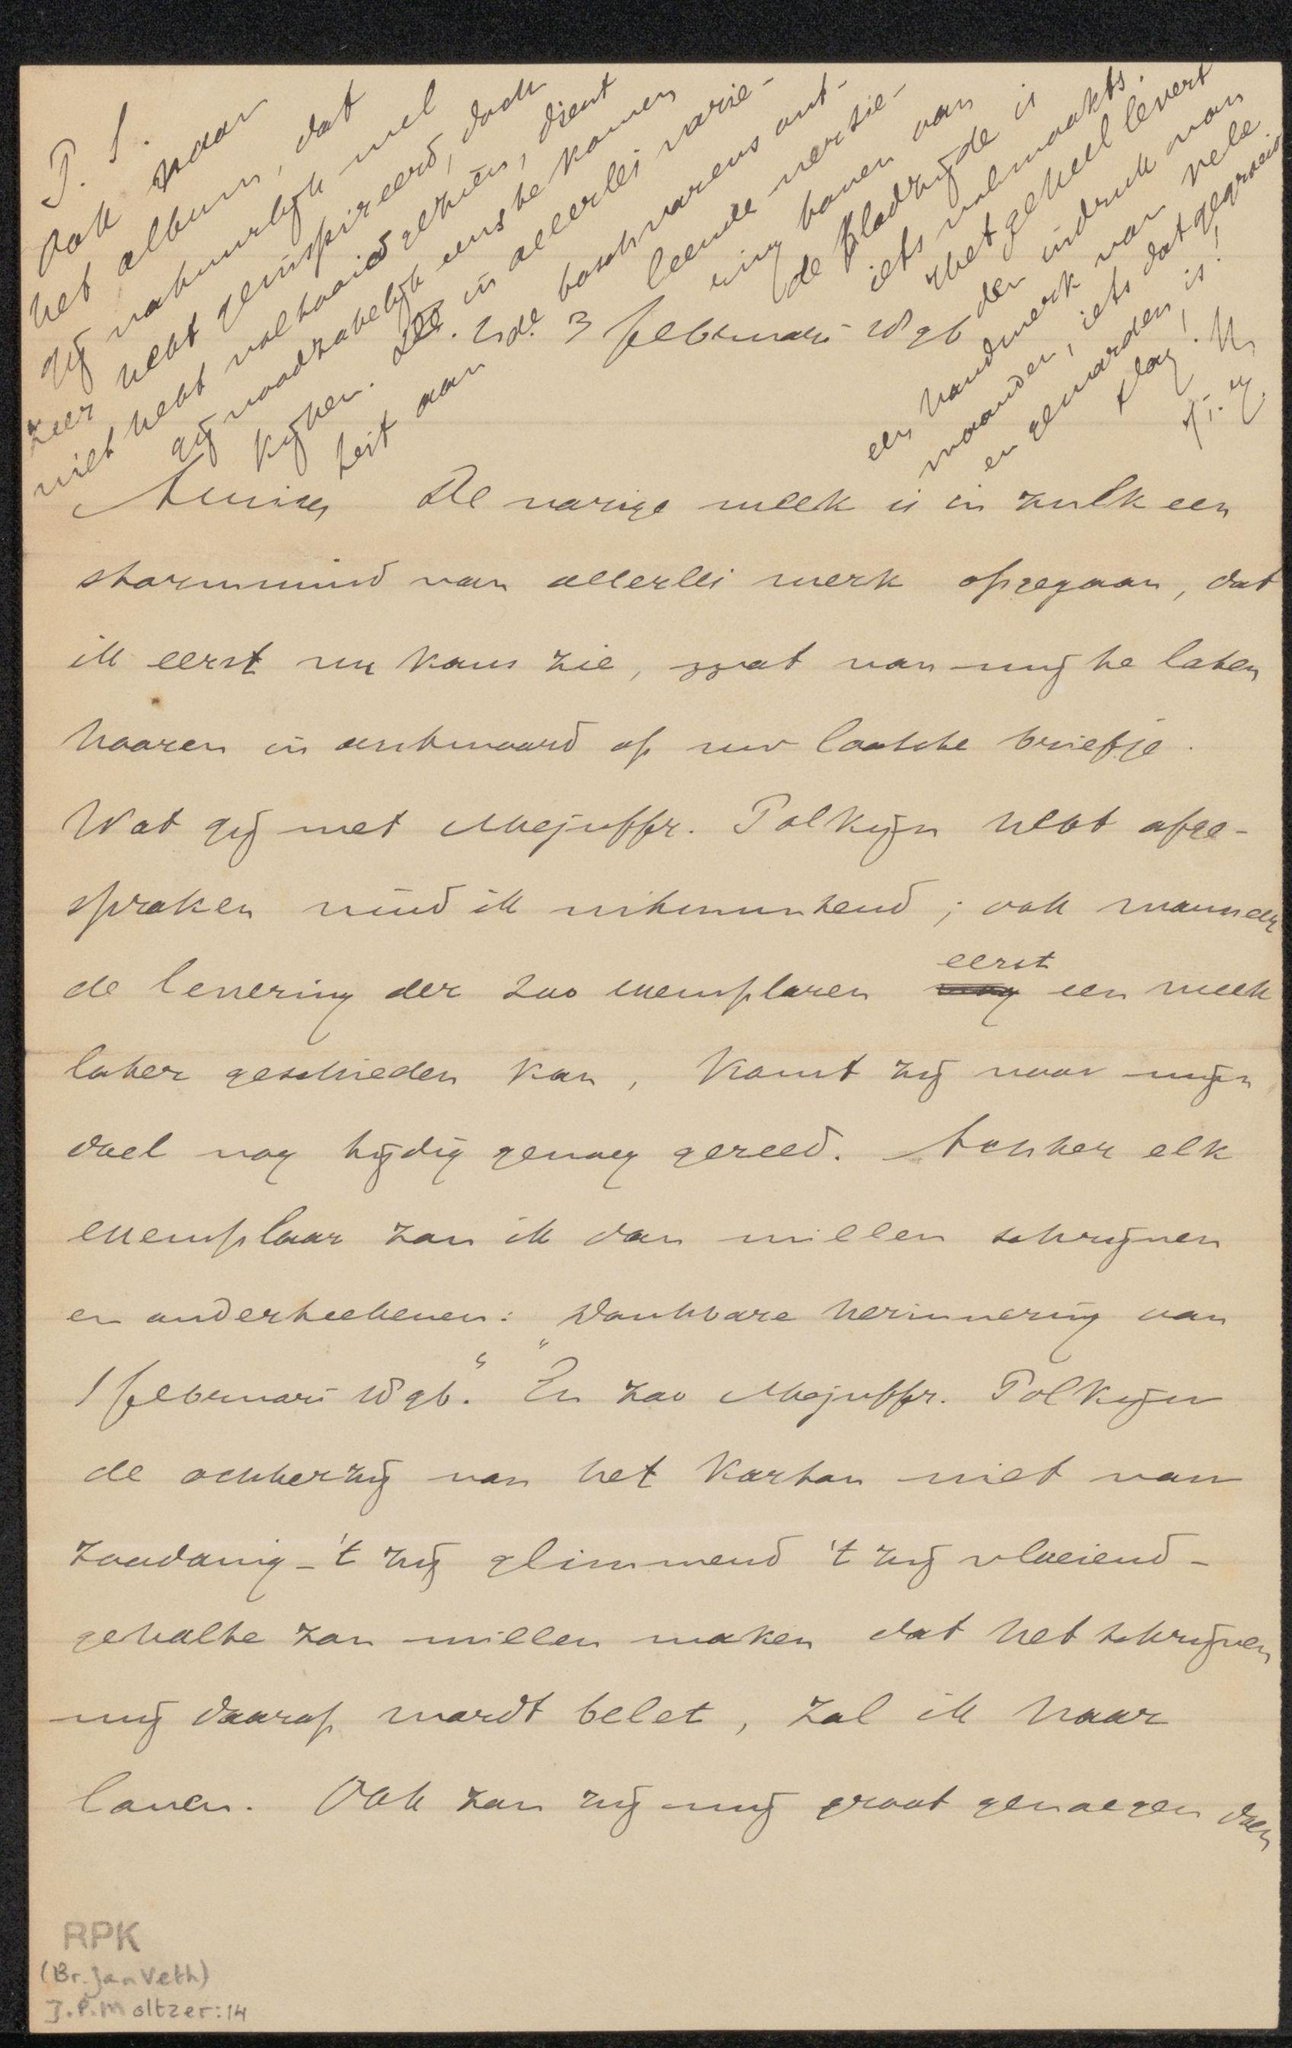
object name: letter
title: Brief aan Jan Veth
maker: jacob pieter moltzer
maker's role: jurist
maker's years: 1850-1907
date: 1896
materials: ink, paper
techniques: pen, writing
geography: the hague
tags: dordrecht, amsterdam, painter, print maker, draughtsman, designer, jan veth, photography, cinematography, historical persons (portraits and scenes from the life), printed matter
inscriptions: collector's mark: ‘RPK’